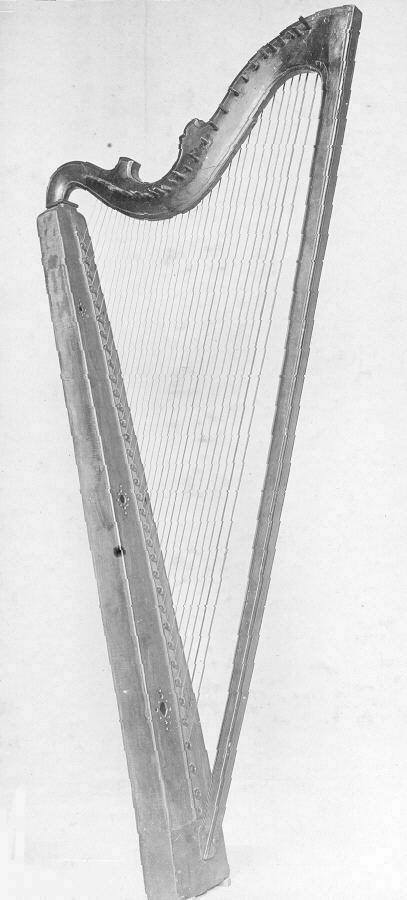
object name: harp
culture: french or german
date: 1760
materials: wood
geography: germany